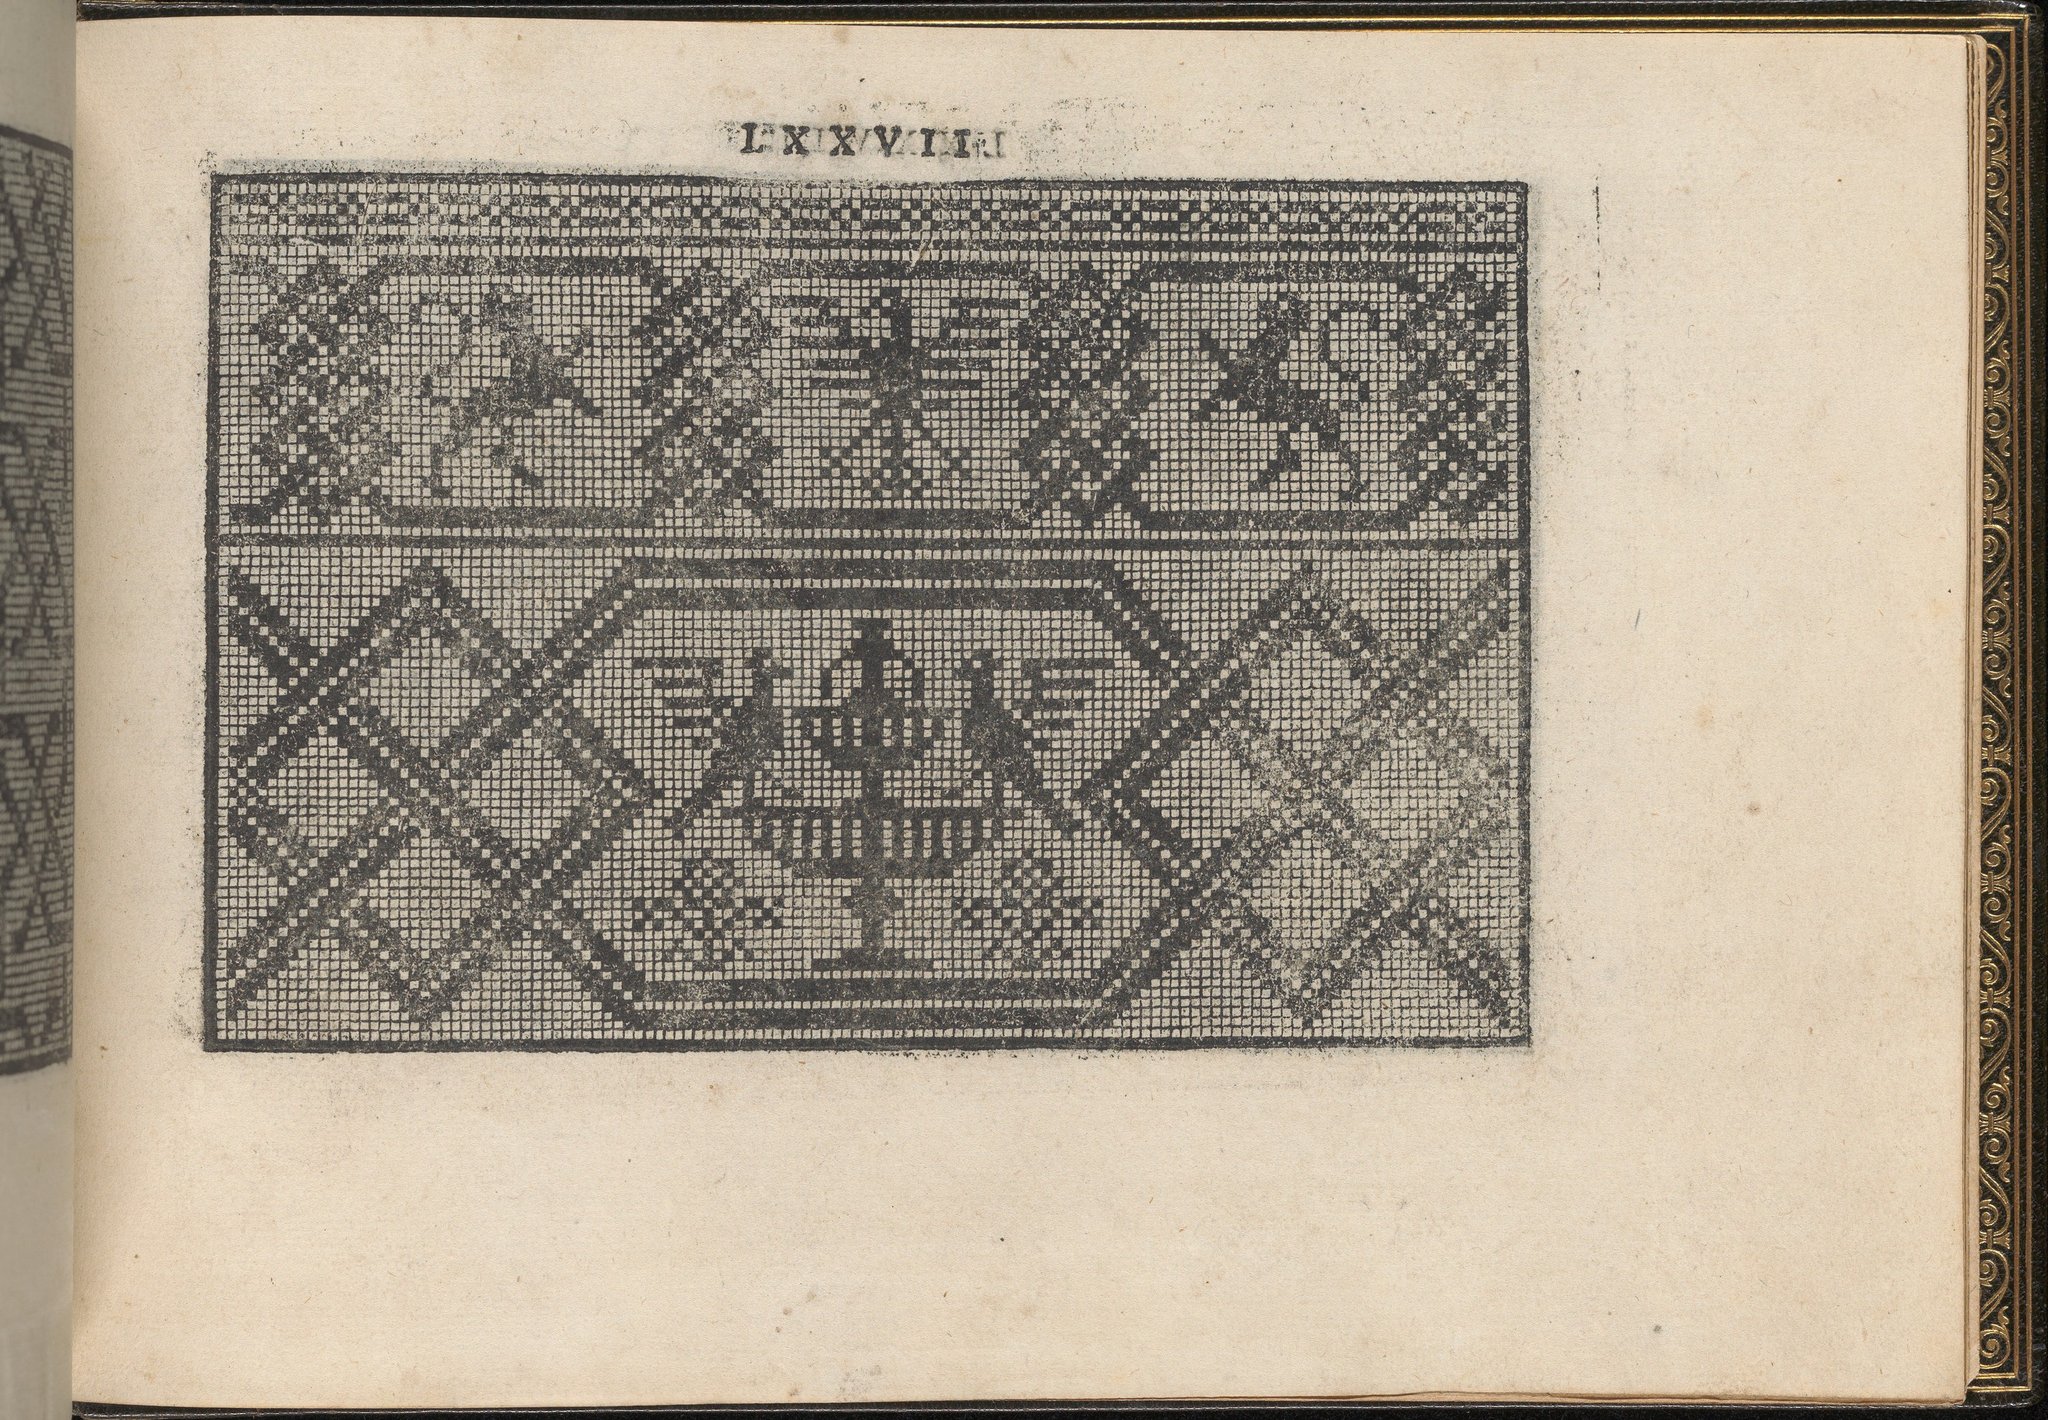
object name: book print ornament architecture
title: La Vera Perfettione del Disegno di varie sorti di recami, page 39 (recto)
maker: giovanni ostaus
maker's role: publisher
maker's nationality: italian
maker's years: 1507-1607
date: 1567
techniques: woodcut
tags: birds,ornament,lions